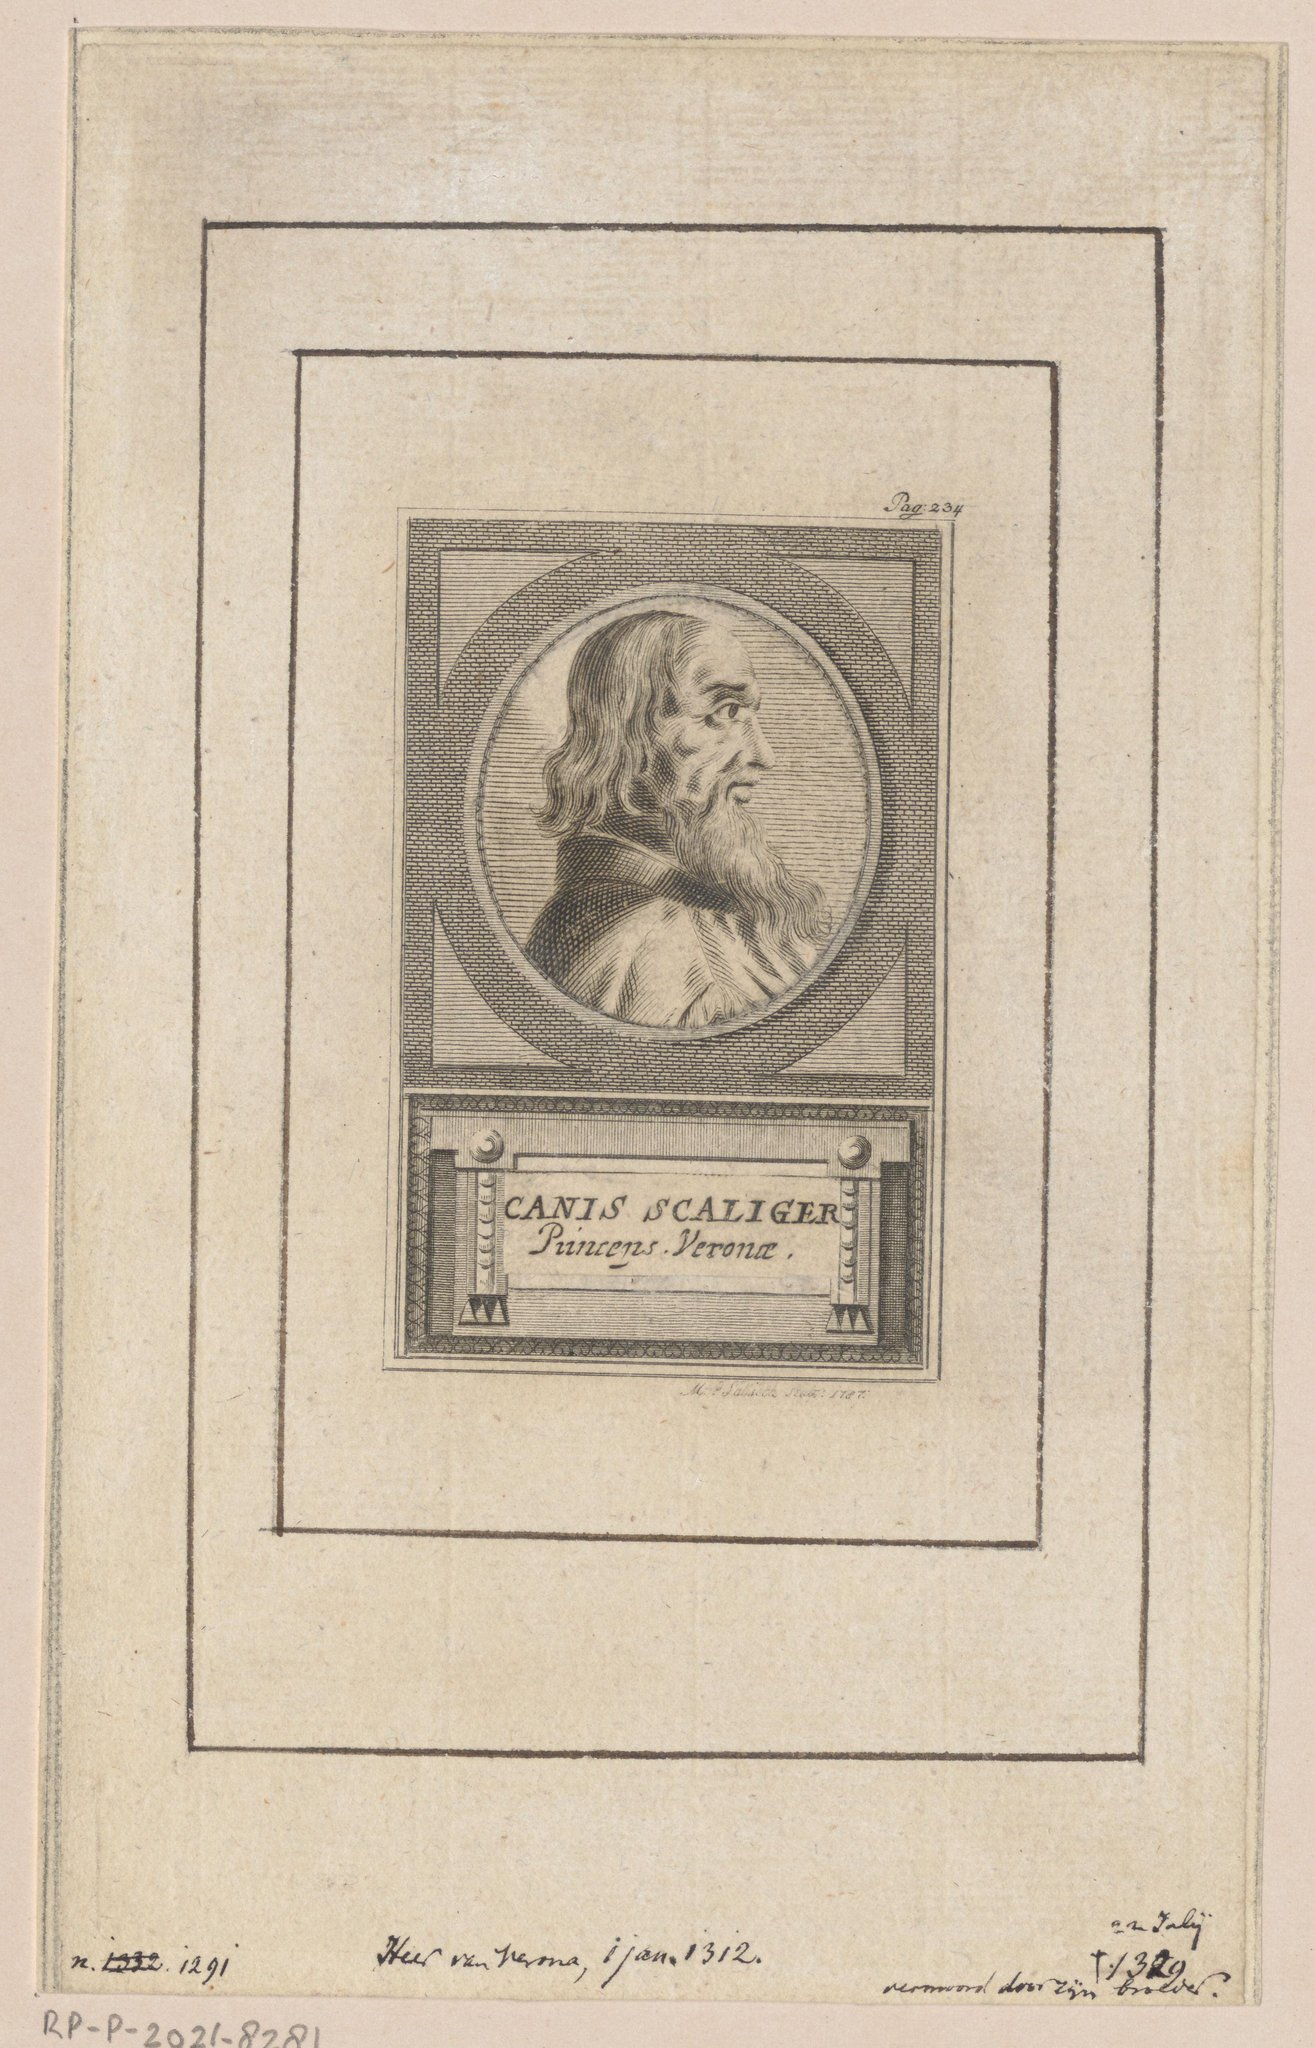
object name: print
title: Portret van Cangrande della Scala II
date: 1688-1787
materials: ink, paper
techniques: engraving, etching, pen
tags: politician, commander-in-chief, general, marshal, historical persons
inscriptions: inscription: ‘n. 1331 1291 Heer van Verona (...)’, inscription: ‘[...] Hoogstraten’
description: Portret en onderschrift maken deel uit van een grotere prent die later is verknipt. Prent waarschijnlijk uit: Freher, Paul. Theatrum virorum eruditione clarorum. Neurenberg: Johann Hoffmann, 1688.